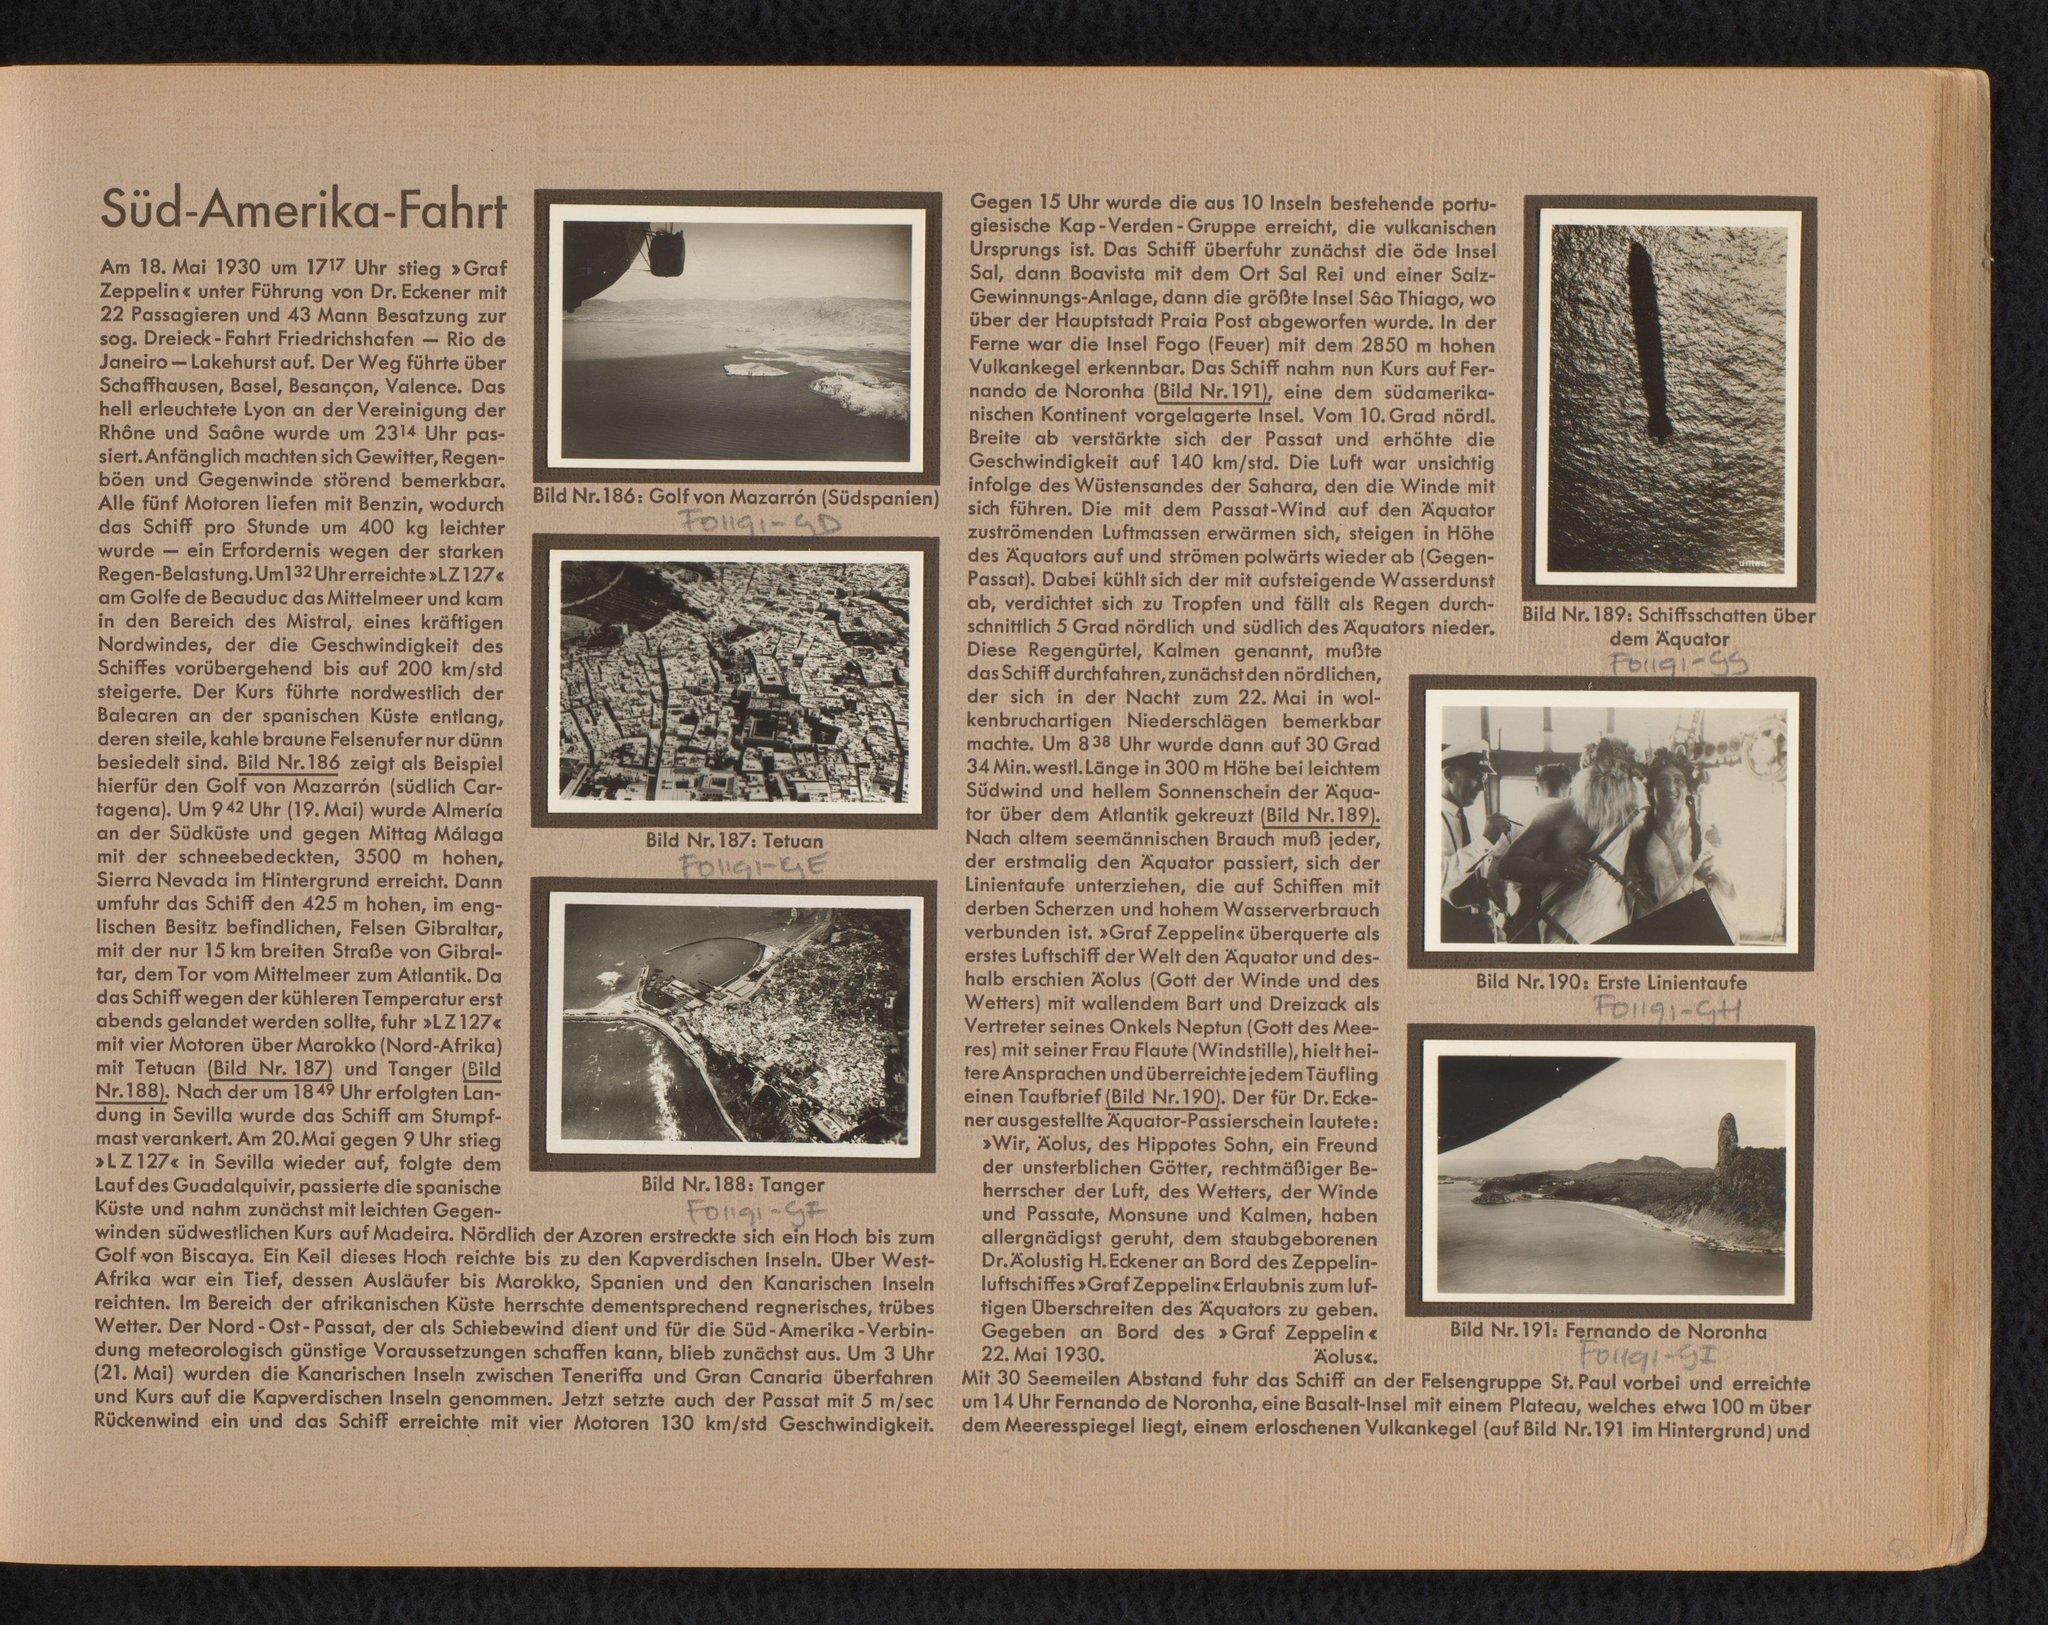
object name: photograph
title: Uitzichten tijdens een vlucht naar Zuid-Amerika door de LZ127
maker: Anonymous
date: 1930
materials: paper, photographic support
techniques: gelatin silver print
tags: city-view, and landscape with man-made constructions, river, beach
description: Zes foto's gemaakt tijdens een vlucht naar Zuid-Amerika, waaronder gezichten op Tétoun, Tanger en Fernando de Noronha. Alle foto's zijn voorzien van een nummer en titel. Deze pagina maakt deel uit van een album.